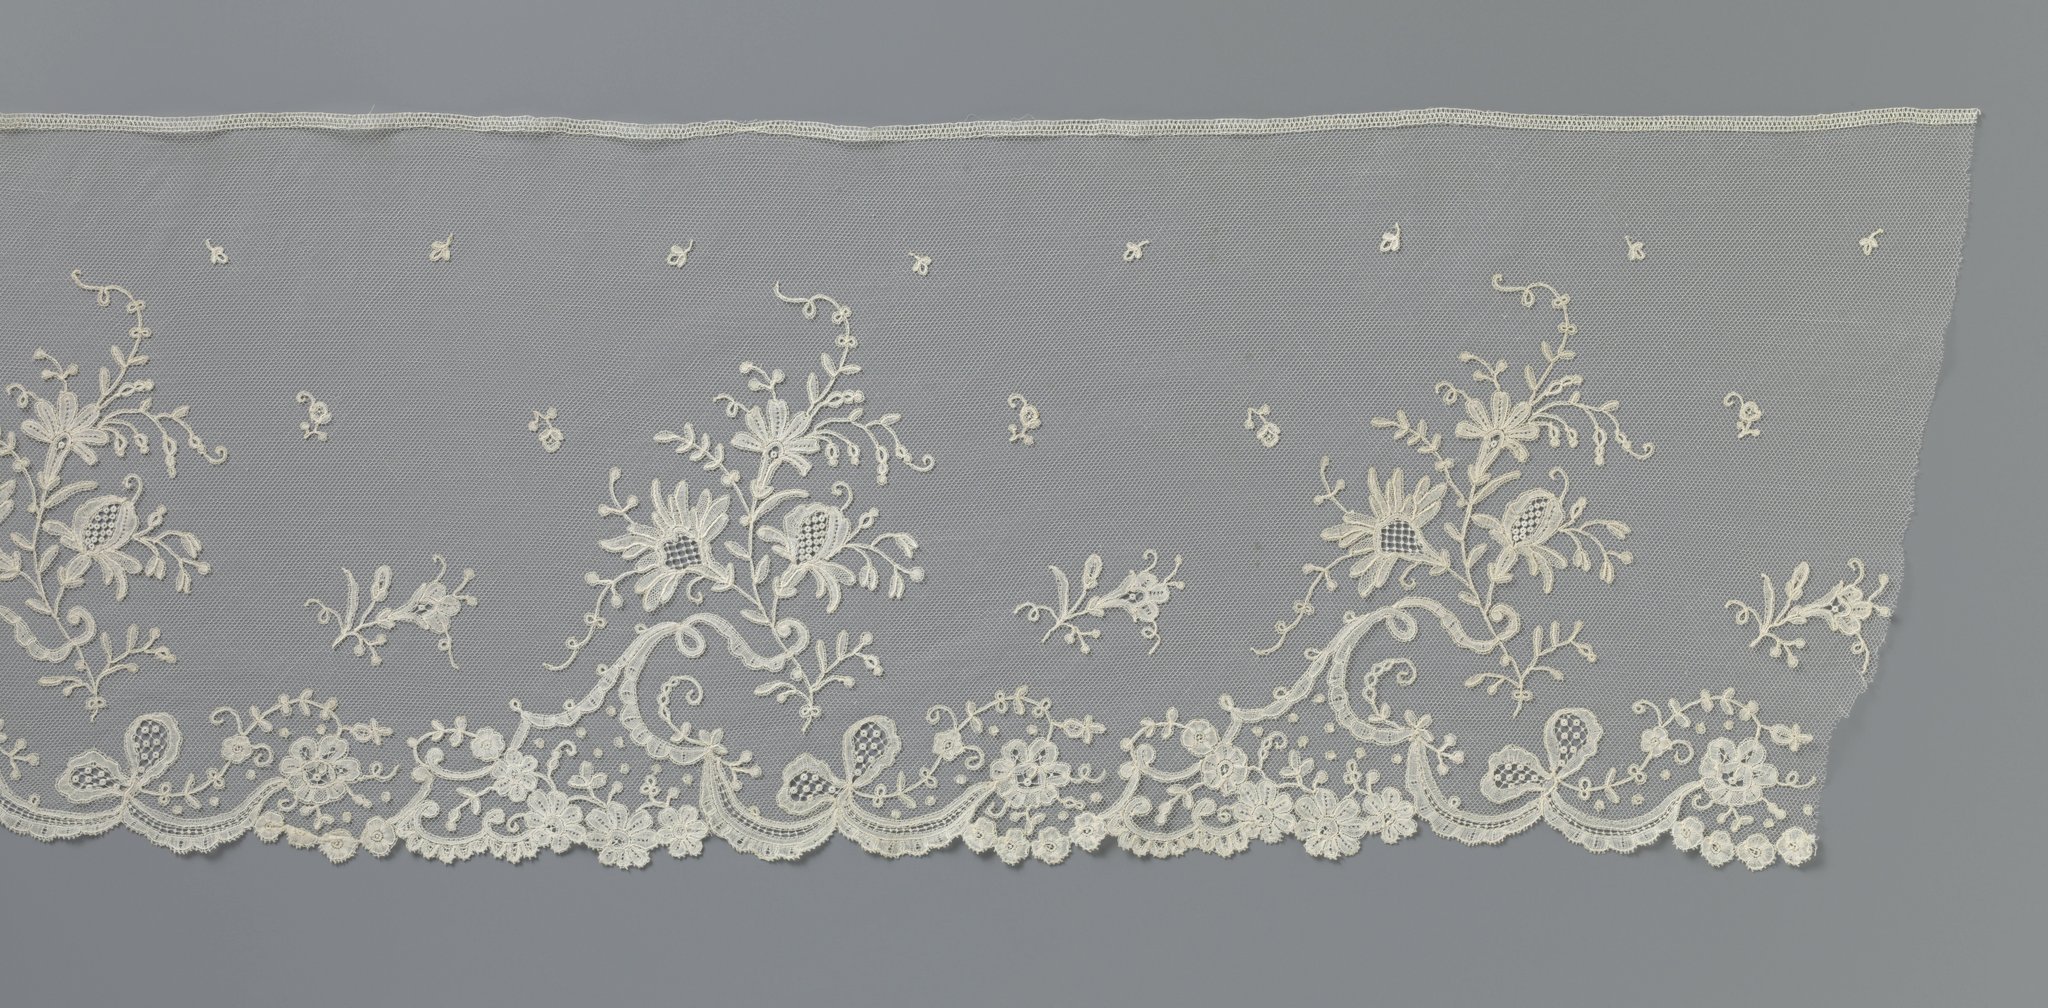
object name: dust ruffle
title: Volant van applicatiekant met schuimkoppen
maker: Anonymous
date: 1890-1909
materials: linen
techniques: lace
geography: brussels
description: Volant van naturelkleurige applicatiekant, kloskant geappliceerd op machinale tule. In de bovenhelft worden enkele gestrooide bloempjes onderbroken door een opgaande gezwenkte tak met driesoortige bloemen. De rand is gevuld met bloemen en ononderbroken geschulpt bandwerk, dat in de vorm van schuimkoppen van omrollende golven is gelegd. Door een strik is een takje met duinroosje hieraan verbonden.